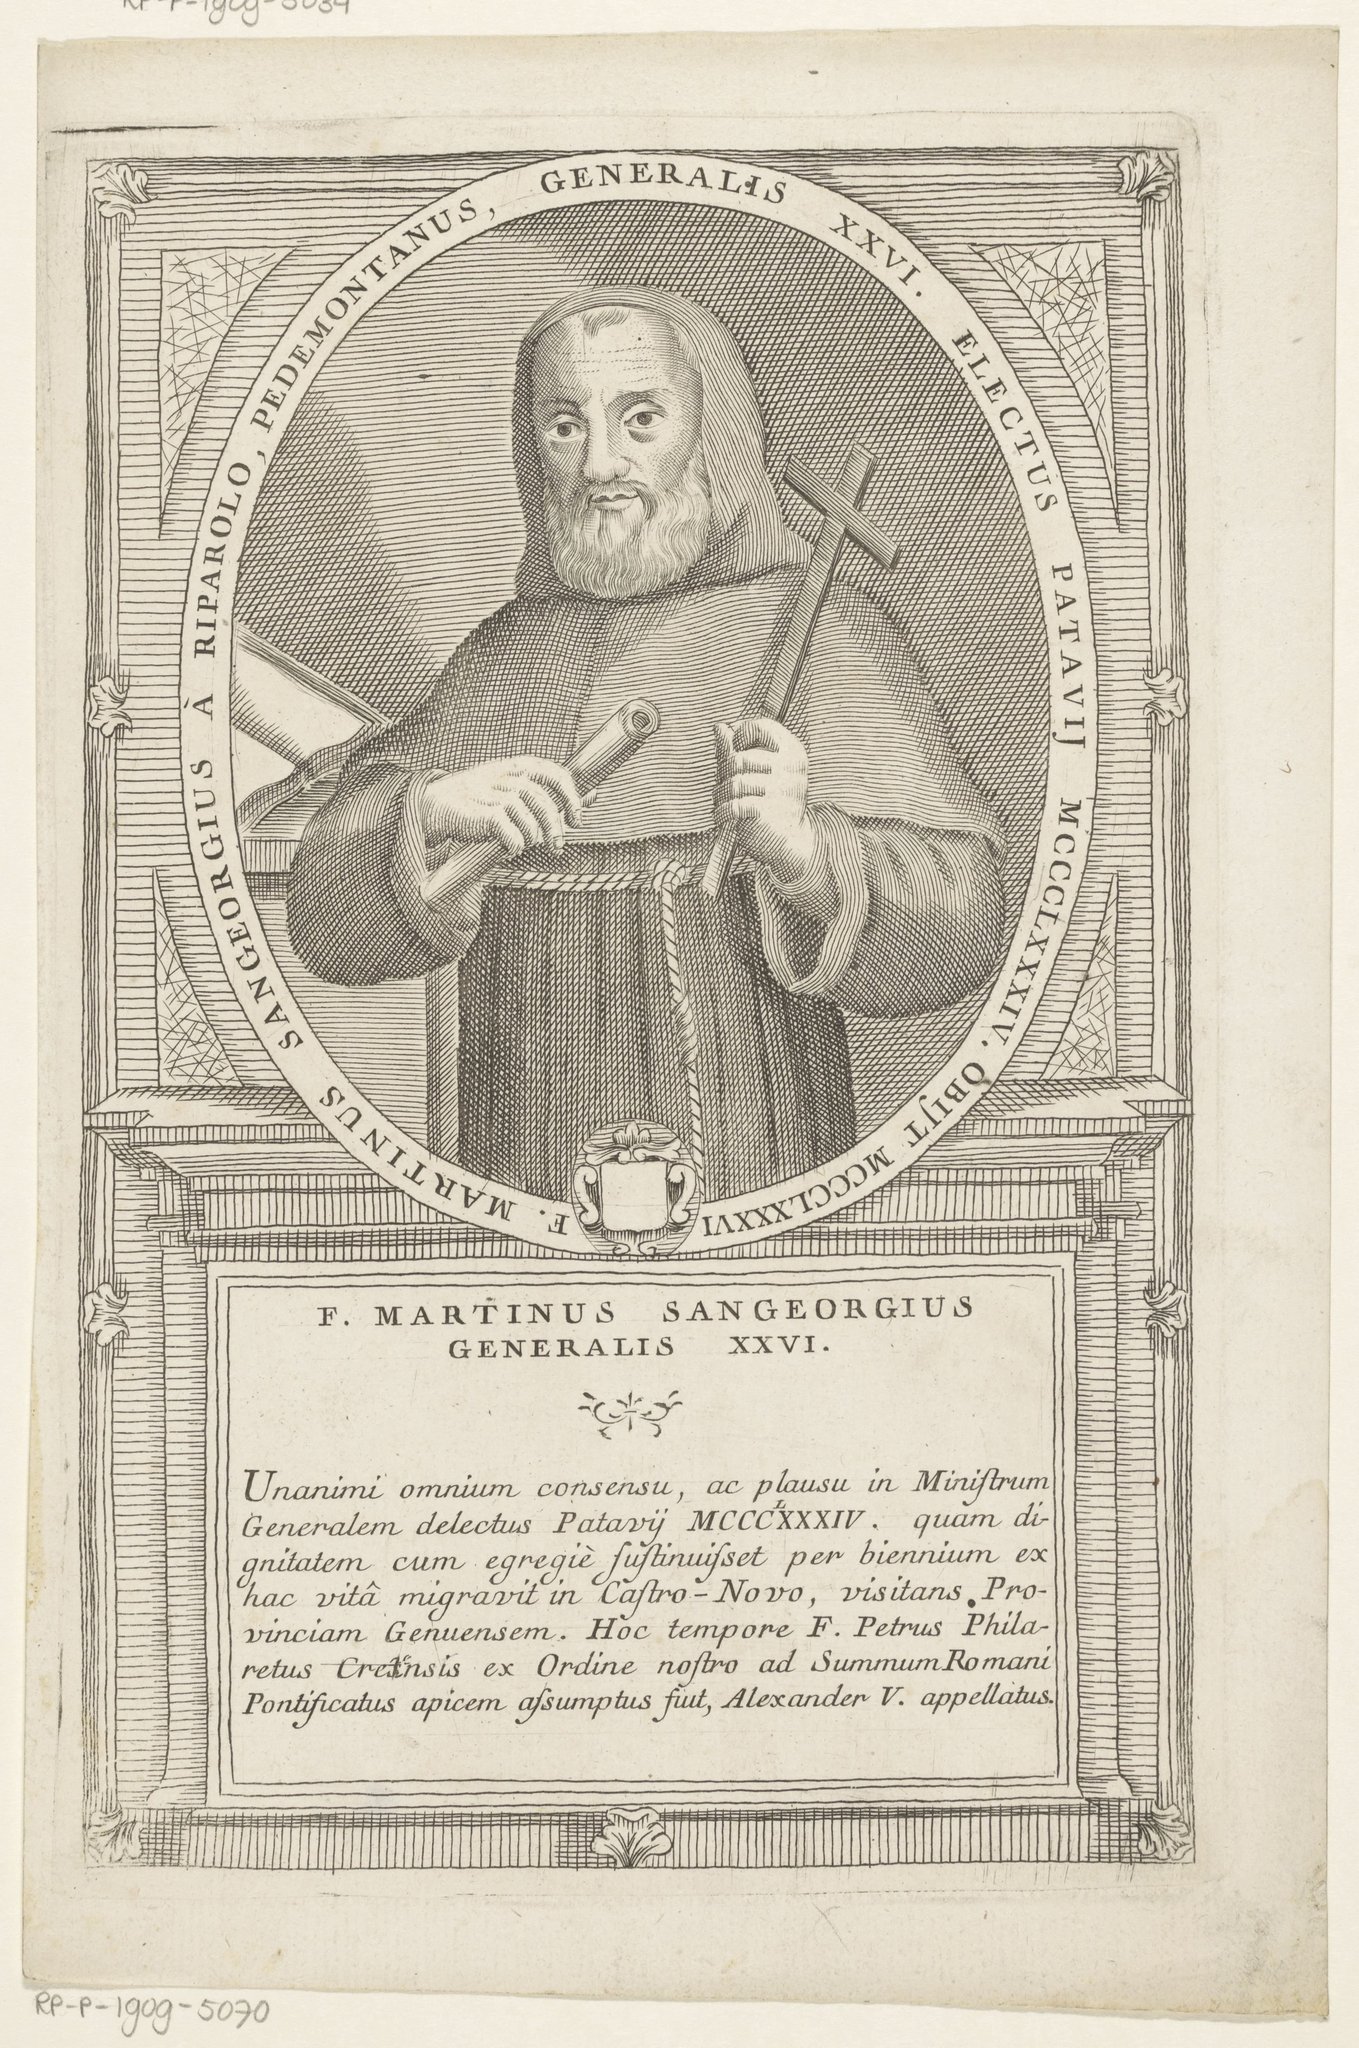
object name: print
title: Portret van Martino Sangiorgio, 26ste Minister Generaal van de franciscaner orde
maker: antonio luciani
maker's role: print maker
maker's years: 1700-1738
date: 1710-1738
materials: paper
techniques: engraving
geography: italy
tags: clergyman, historical persons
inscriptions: collector's mark: Lugt 2228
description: Deze prent maakt deel uit van een groep van 60 portretten.